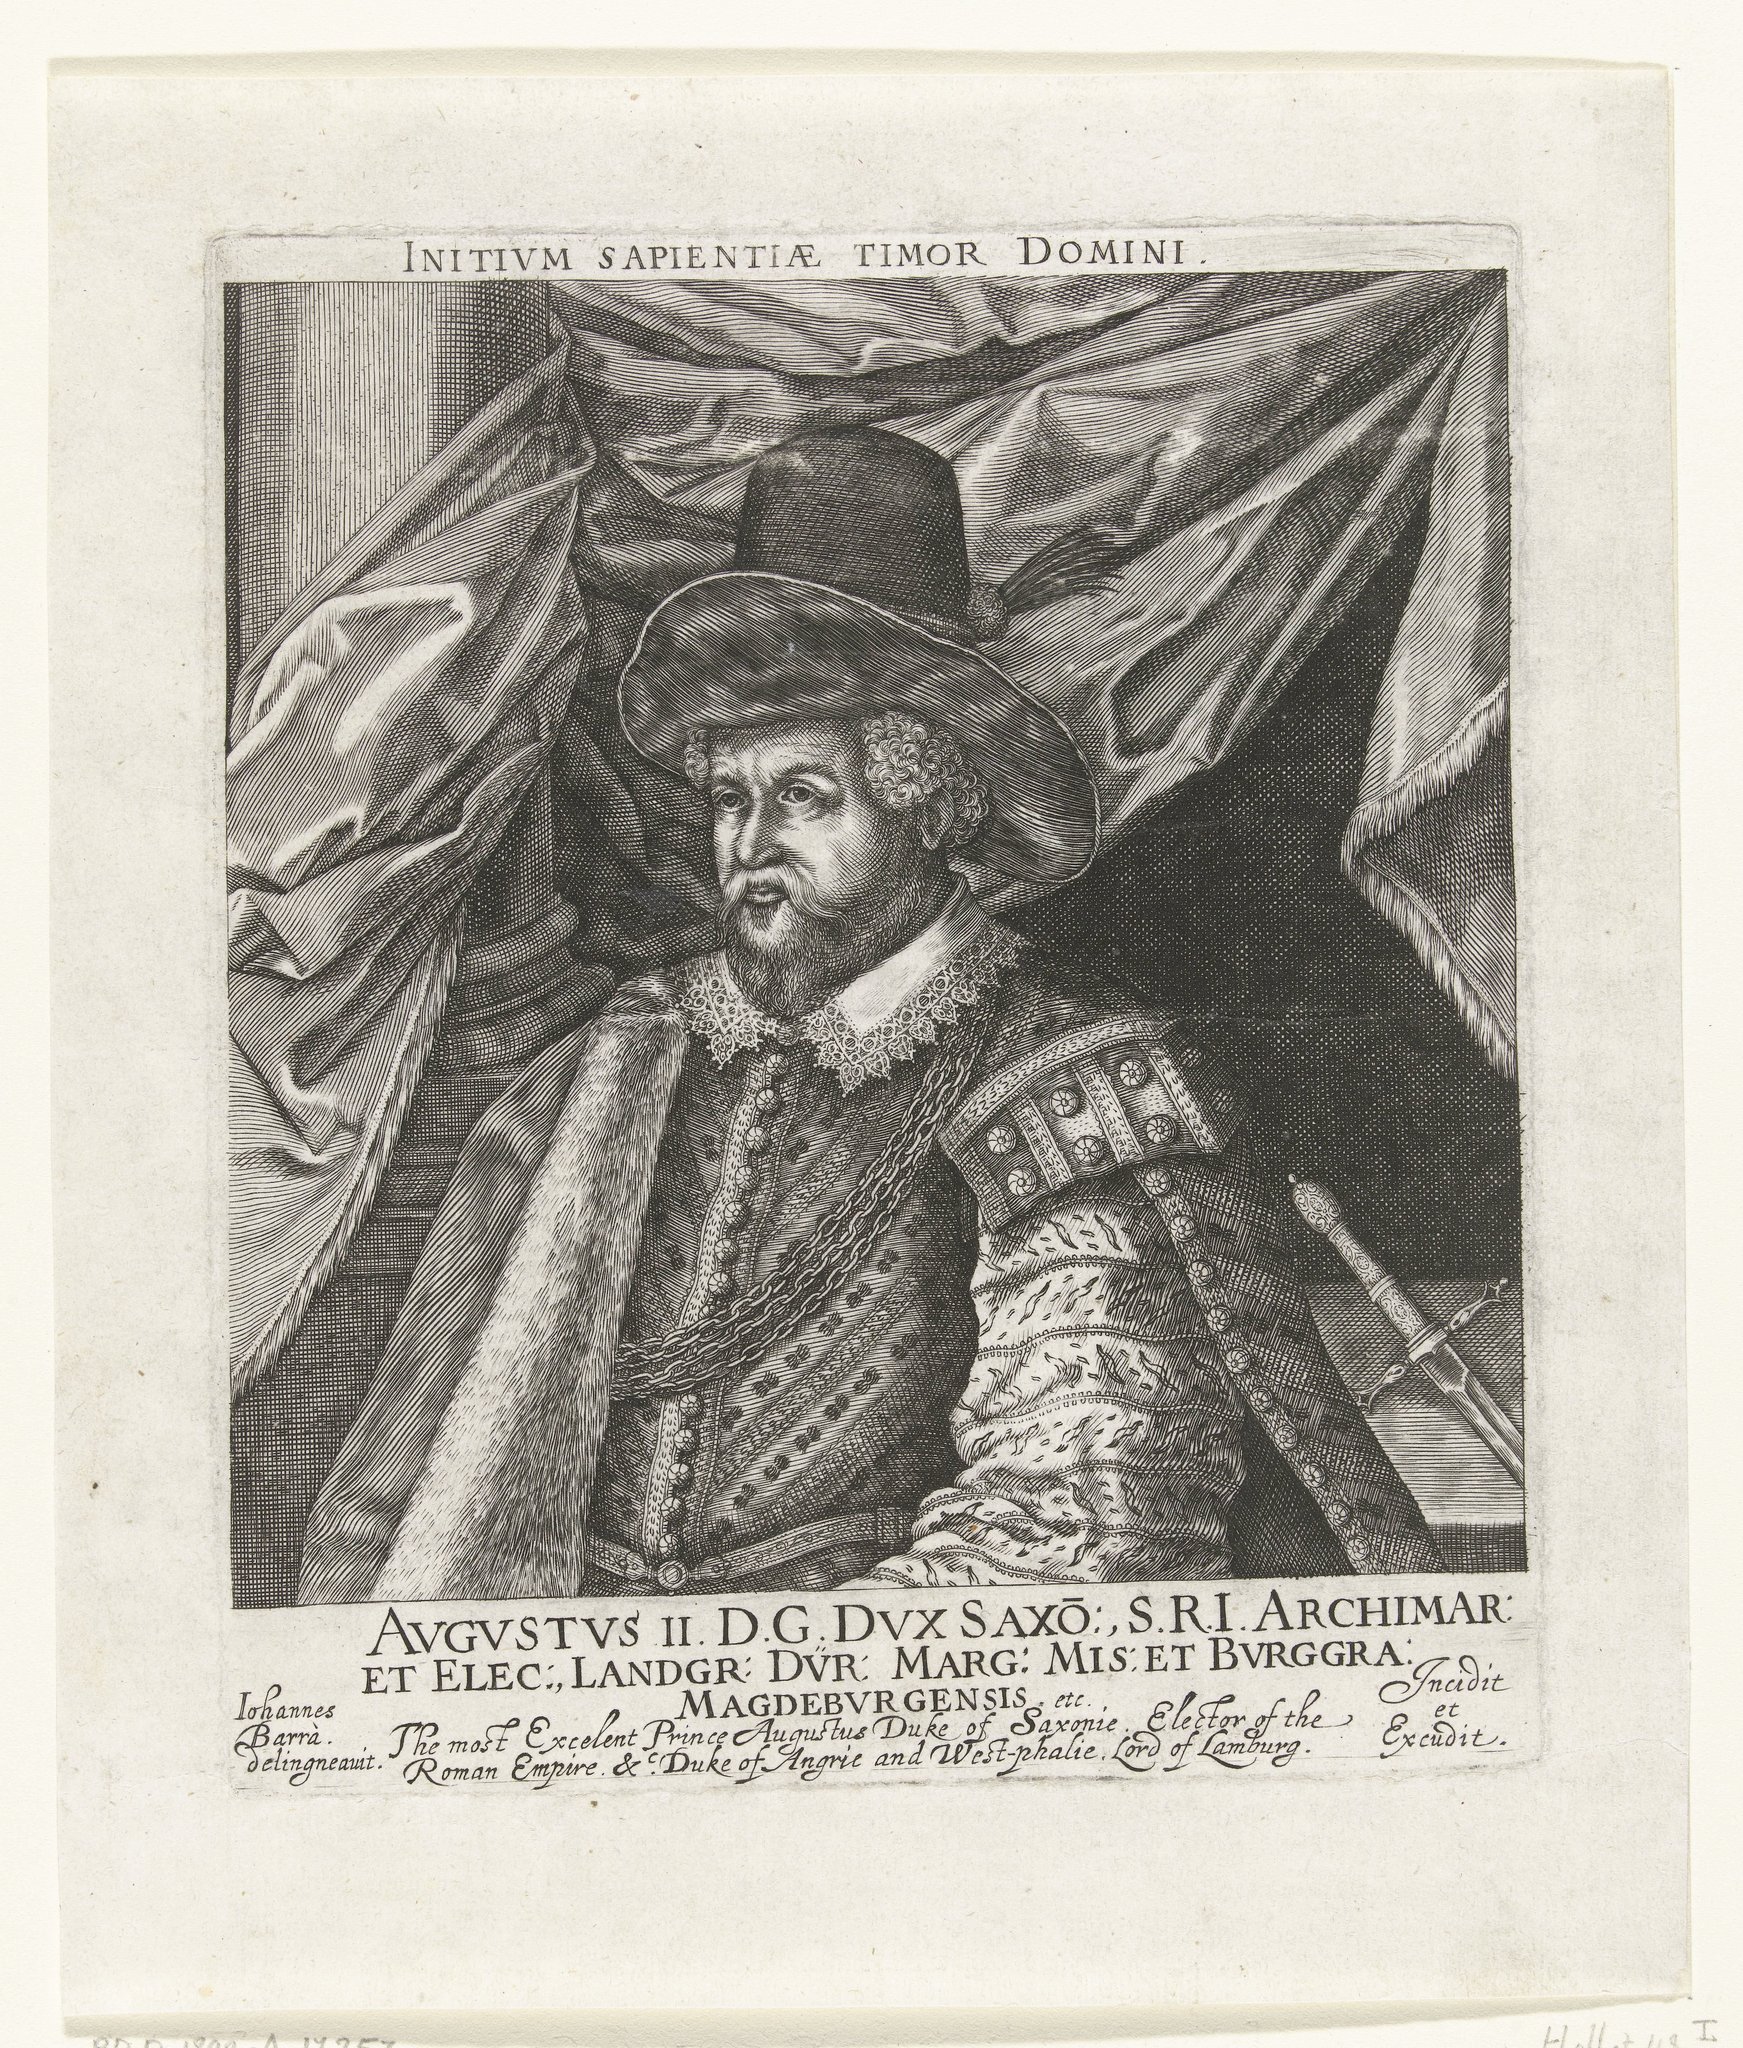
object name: print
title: Avgvstvs II DG Dvx (...) Bvrggra: Magdebvrgensis etc.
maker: johan barra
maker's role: print maker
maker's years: 1581-1634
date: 1603-1634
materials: paper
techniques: engraving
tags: freiberg, dresden, keurvorst, keurvorst van saksen augustus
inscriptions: collector's mark: Lugt 2228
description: Hollstein beschrijft de twee staten niet goed. Deze prent is gedrukt in de tweede staat na de wijziging van de naam van Christiaan II in Augustus II en toevoeging van het Engelse opschrift en de baard van de man.